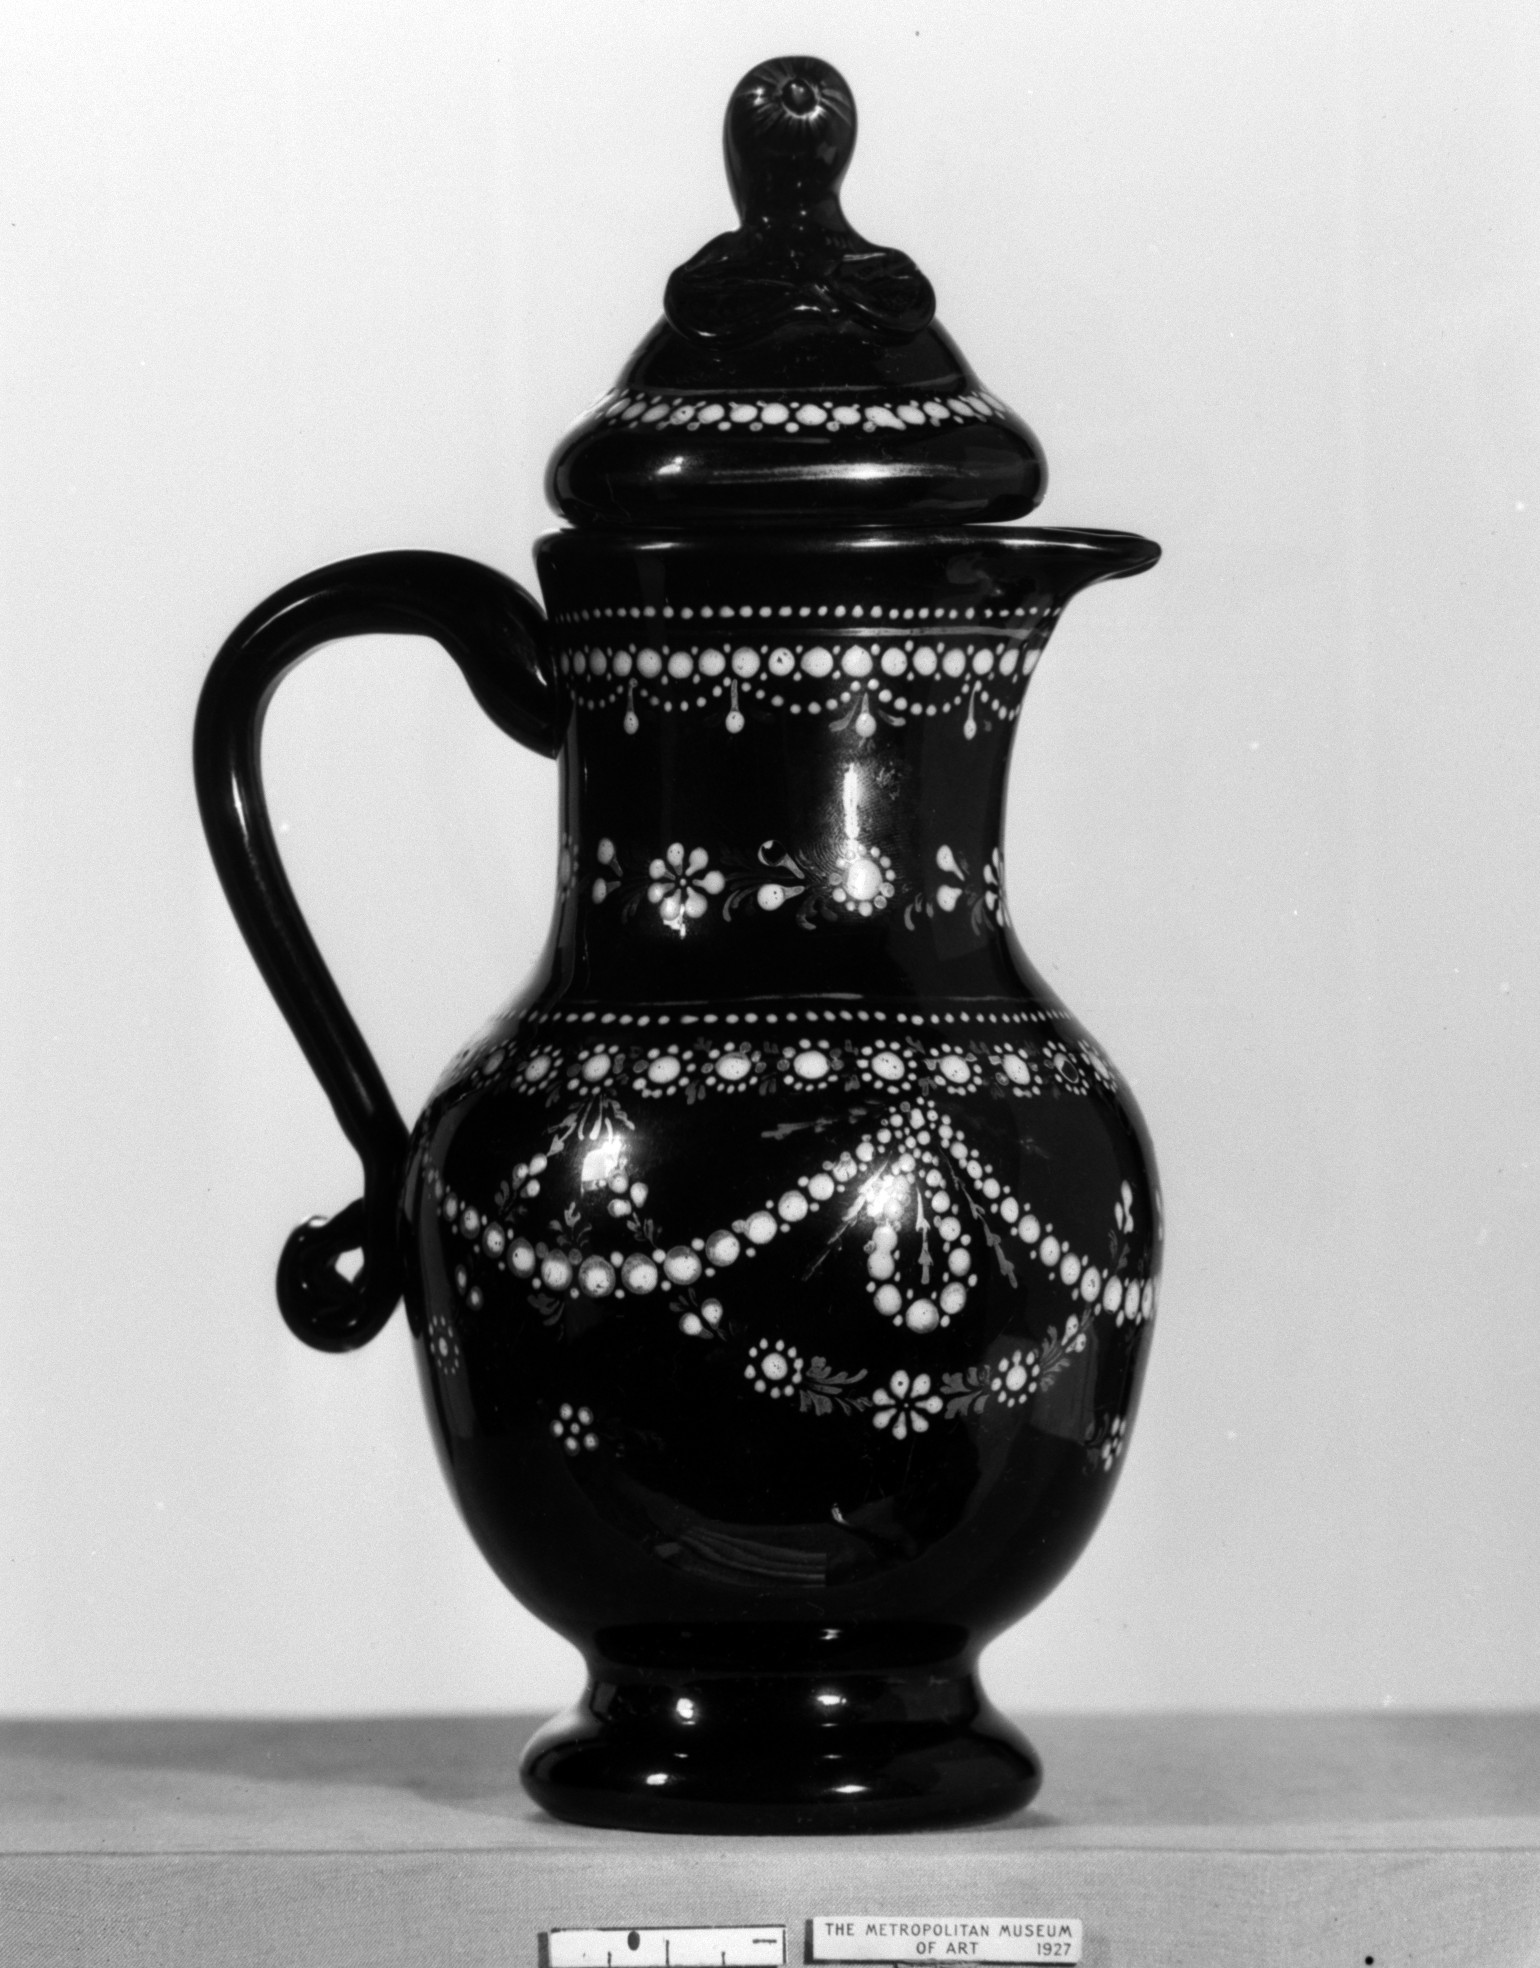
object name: jug with cover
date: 1790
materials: glass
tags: garlands,flowers